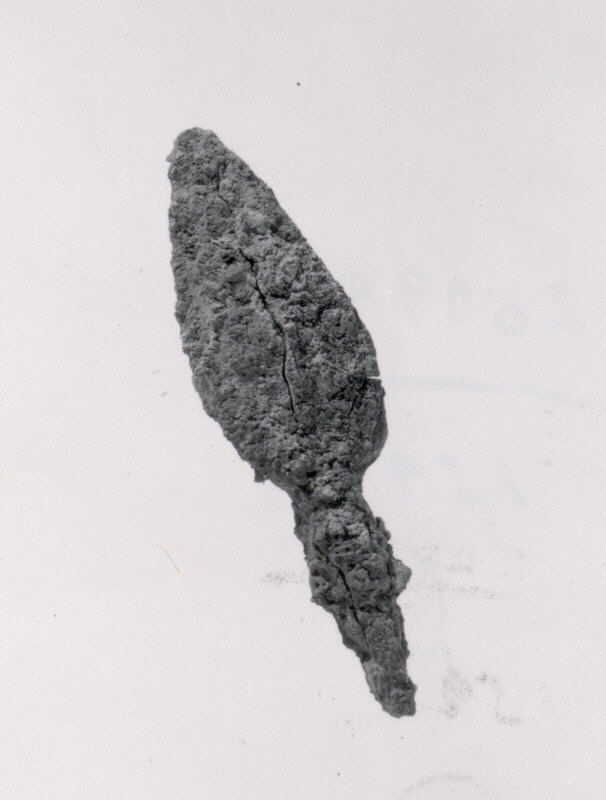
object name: arrowhead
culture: iranian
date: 900-801 BCE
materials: iron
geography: iran